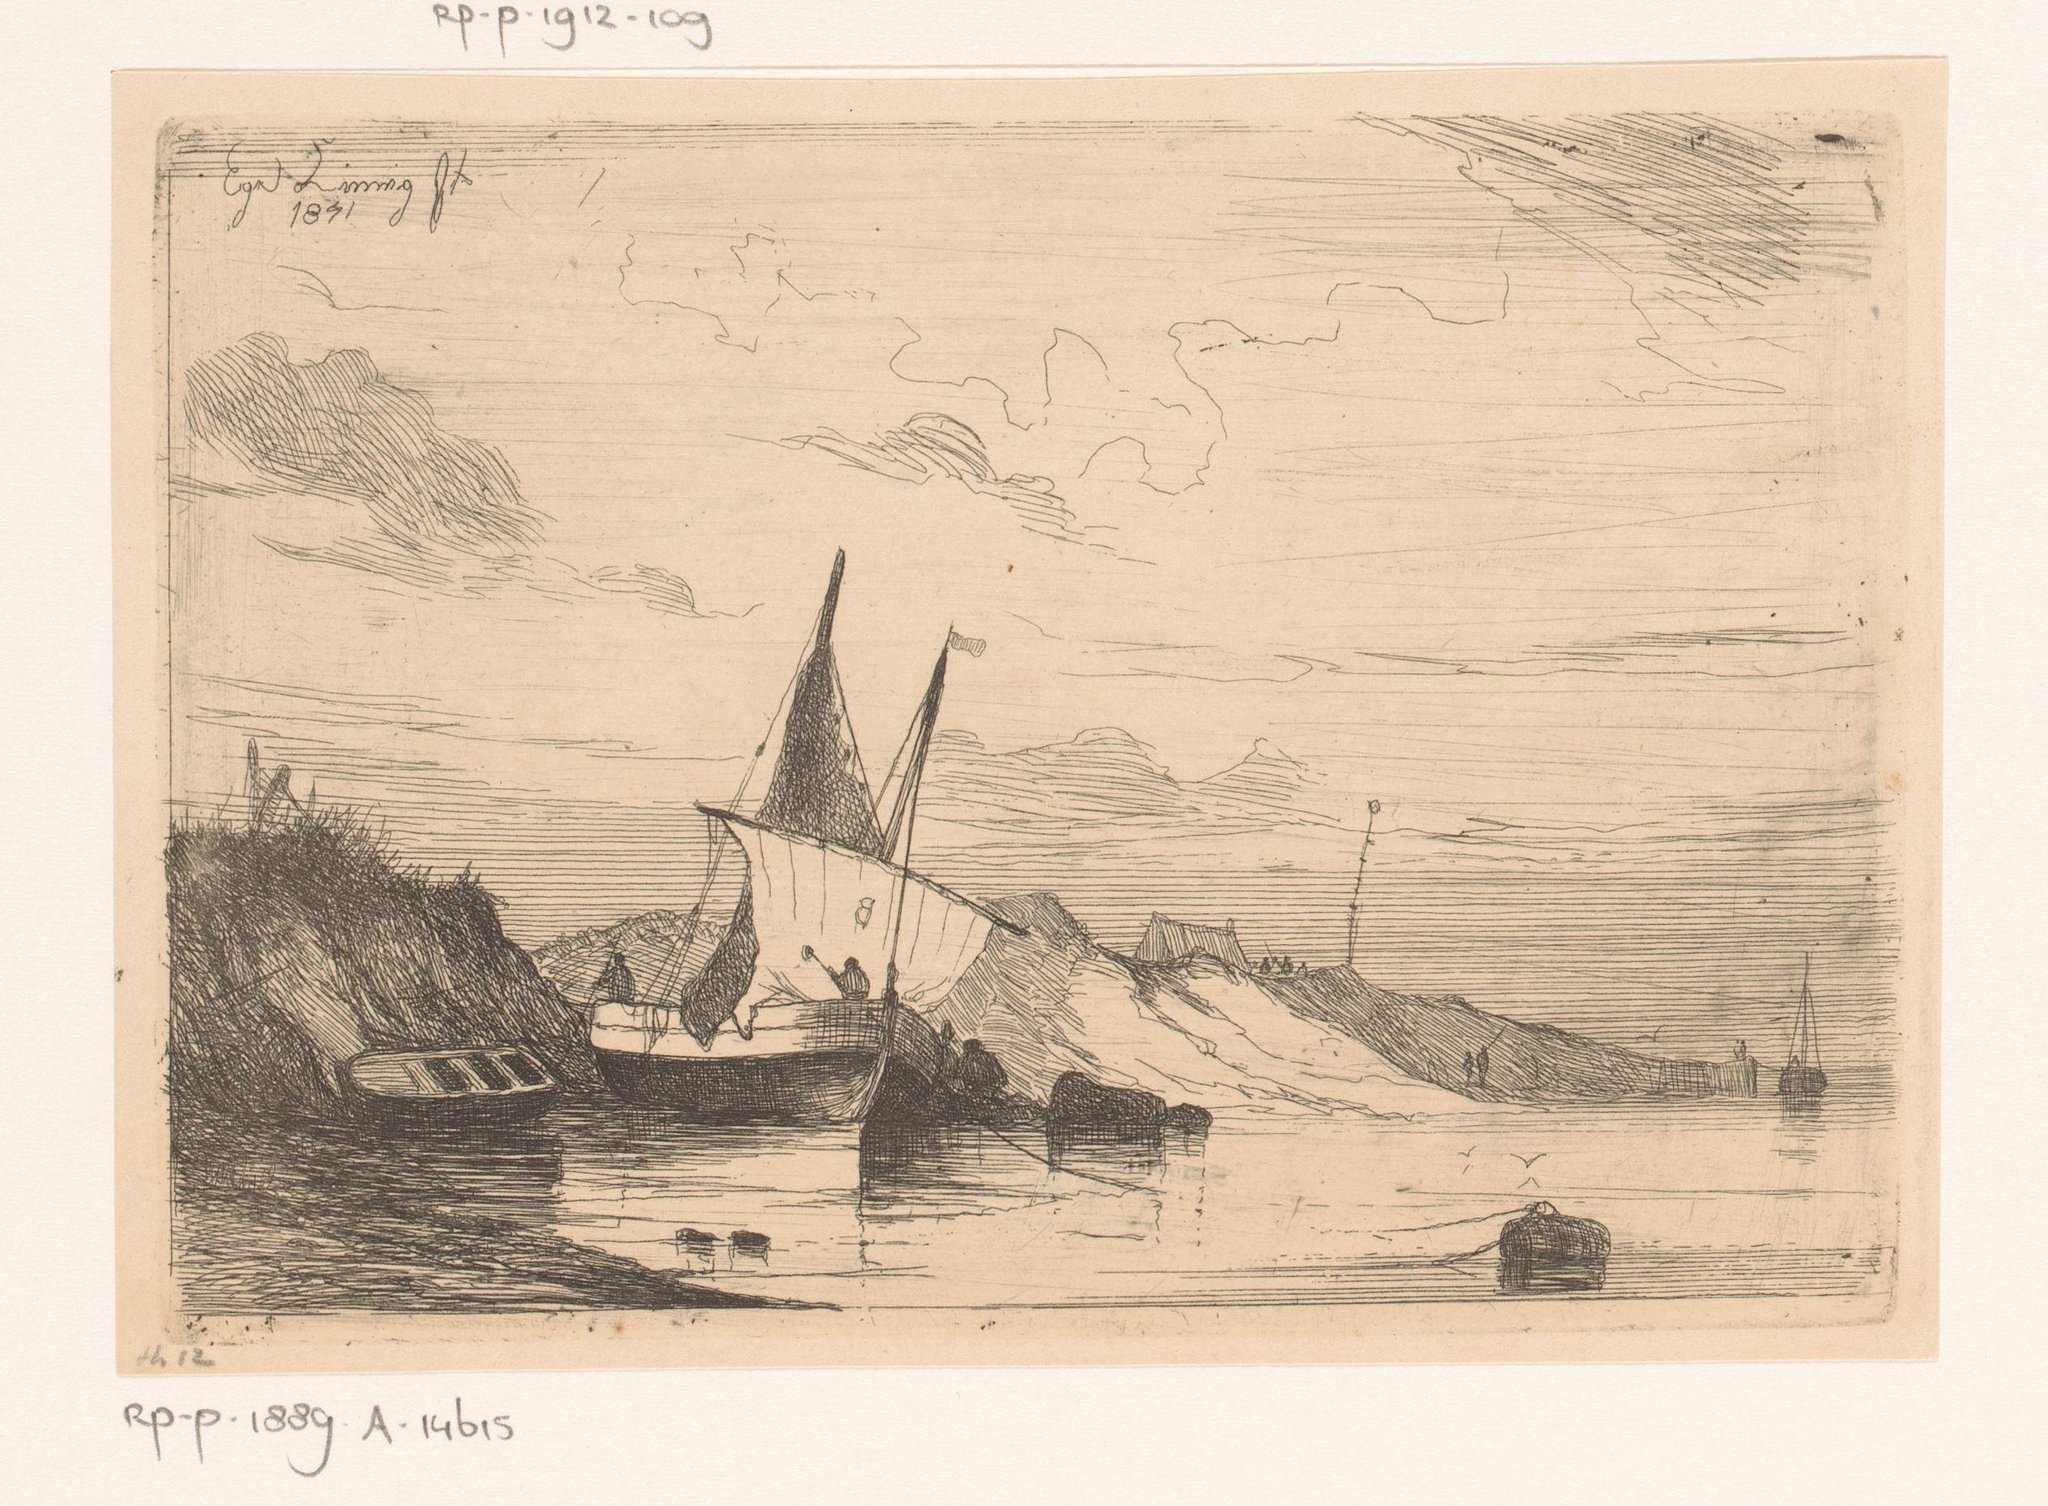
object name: print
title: Vissersboot bij de duinen van Blankenberge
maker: egidius linnig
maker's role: draughtsman, print maker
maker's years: 1821-1860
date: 1841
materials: paper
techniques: etching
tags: dune coast, sailing-ship, sailing-boat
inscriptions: collector's mark: Lugt 2228